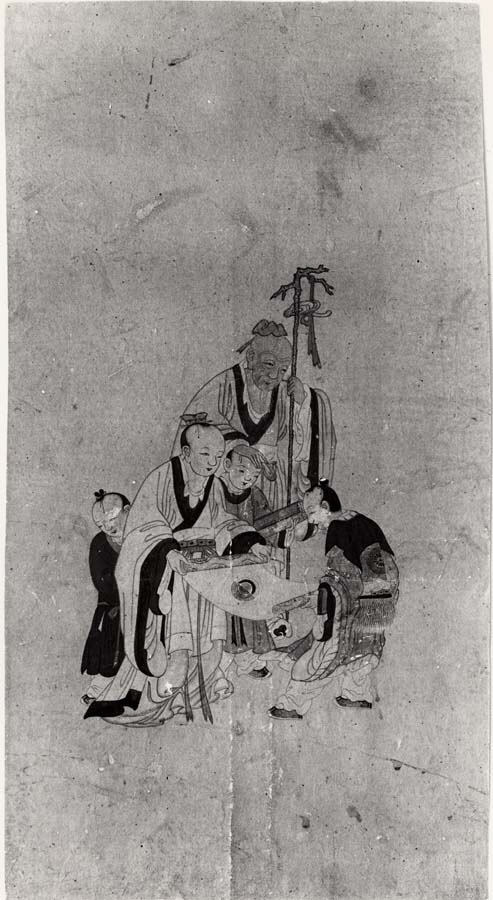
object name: album leaf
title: The Wise Men and Scrolls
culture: korean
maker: unidentified artist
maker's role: artist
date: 1801-1900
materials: ink, paper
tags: children,men